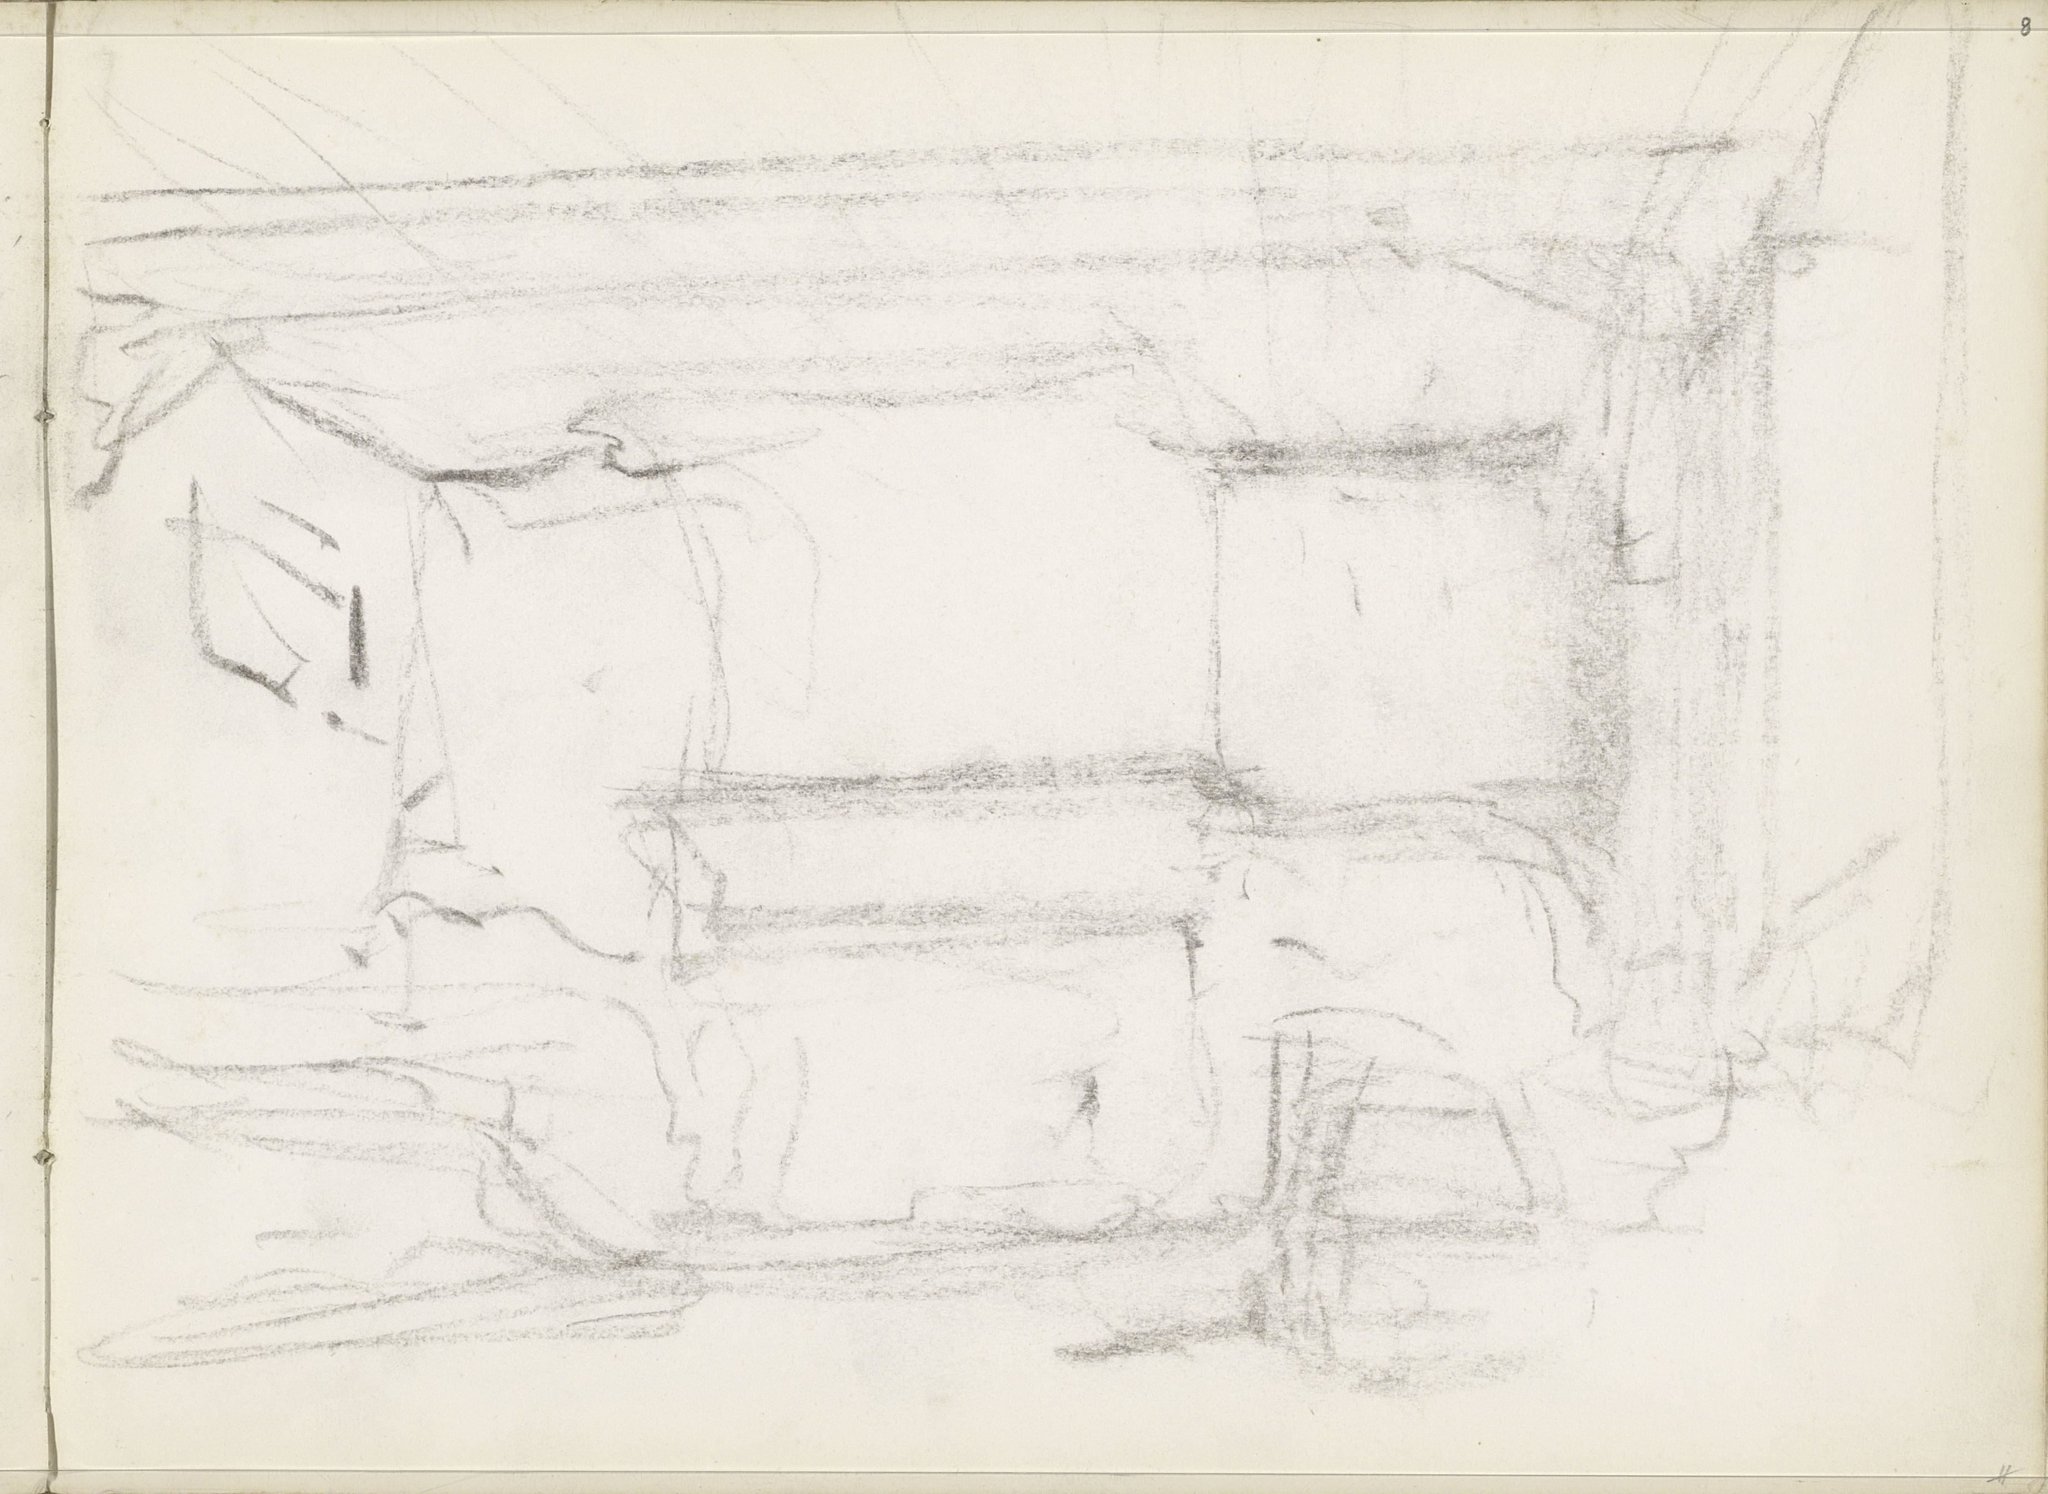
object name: sketchbook leaf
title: Studie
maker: johannes bosboom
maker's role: draughtsman, painter, print maker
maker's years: 1817-1891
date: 1827-1891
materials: chalk, paper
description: Blad 8 recto uit een schetsboek met 13 bladen.